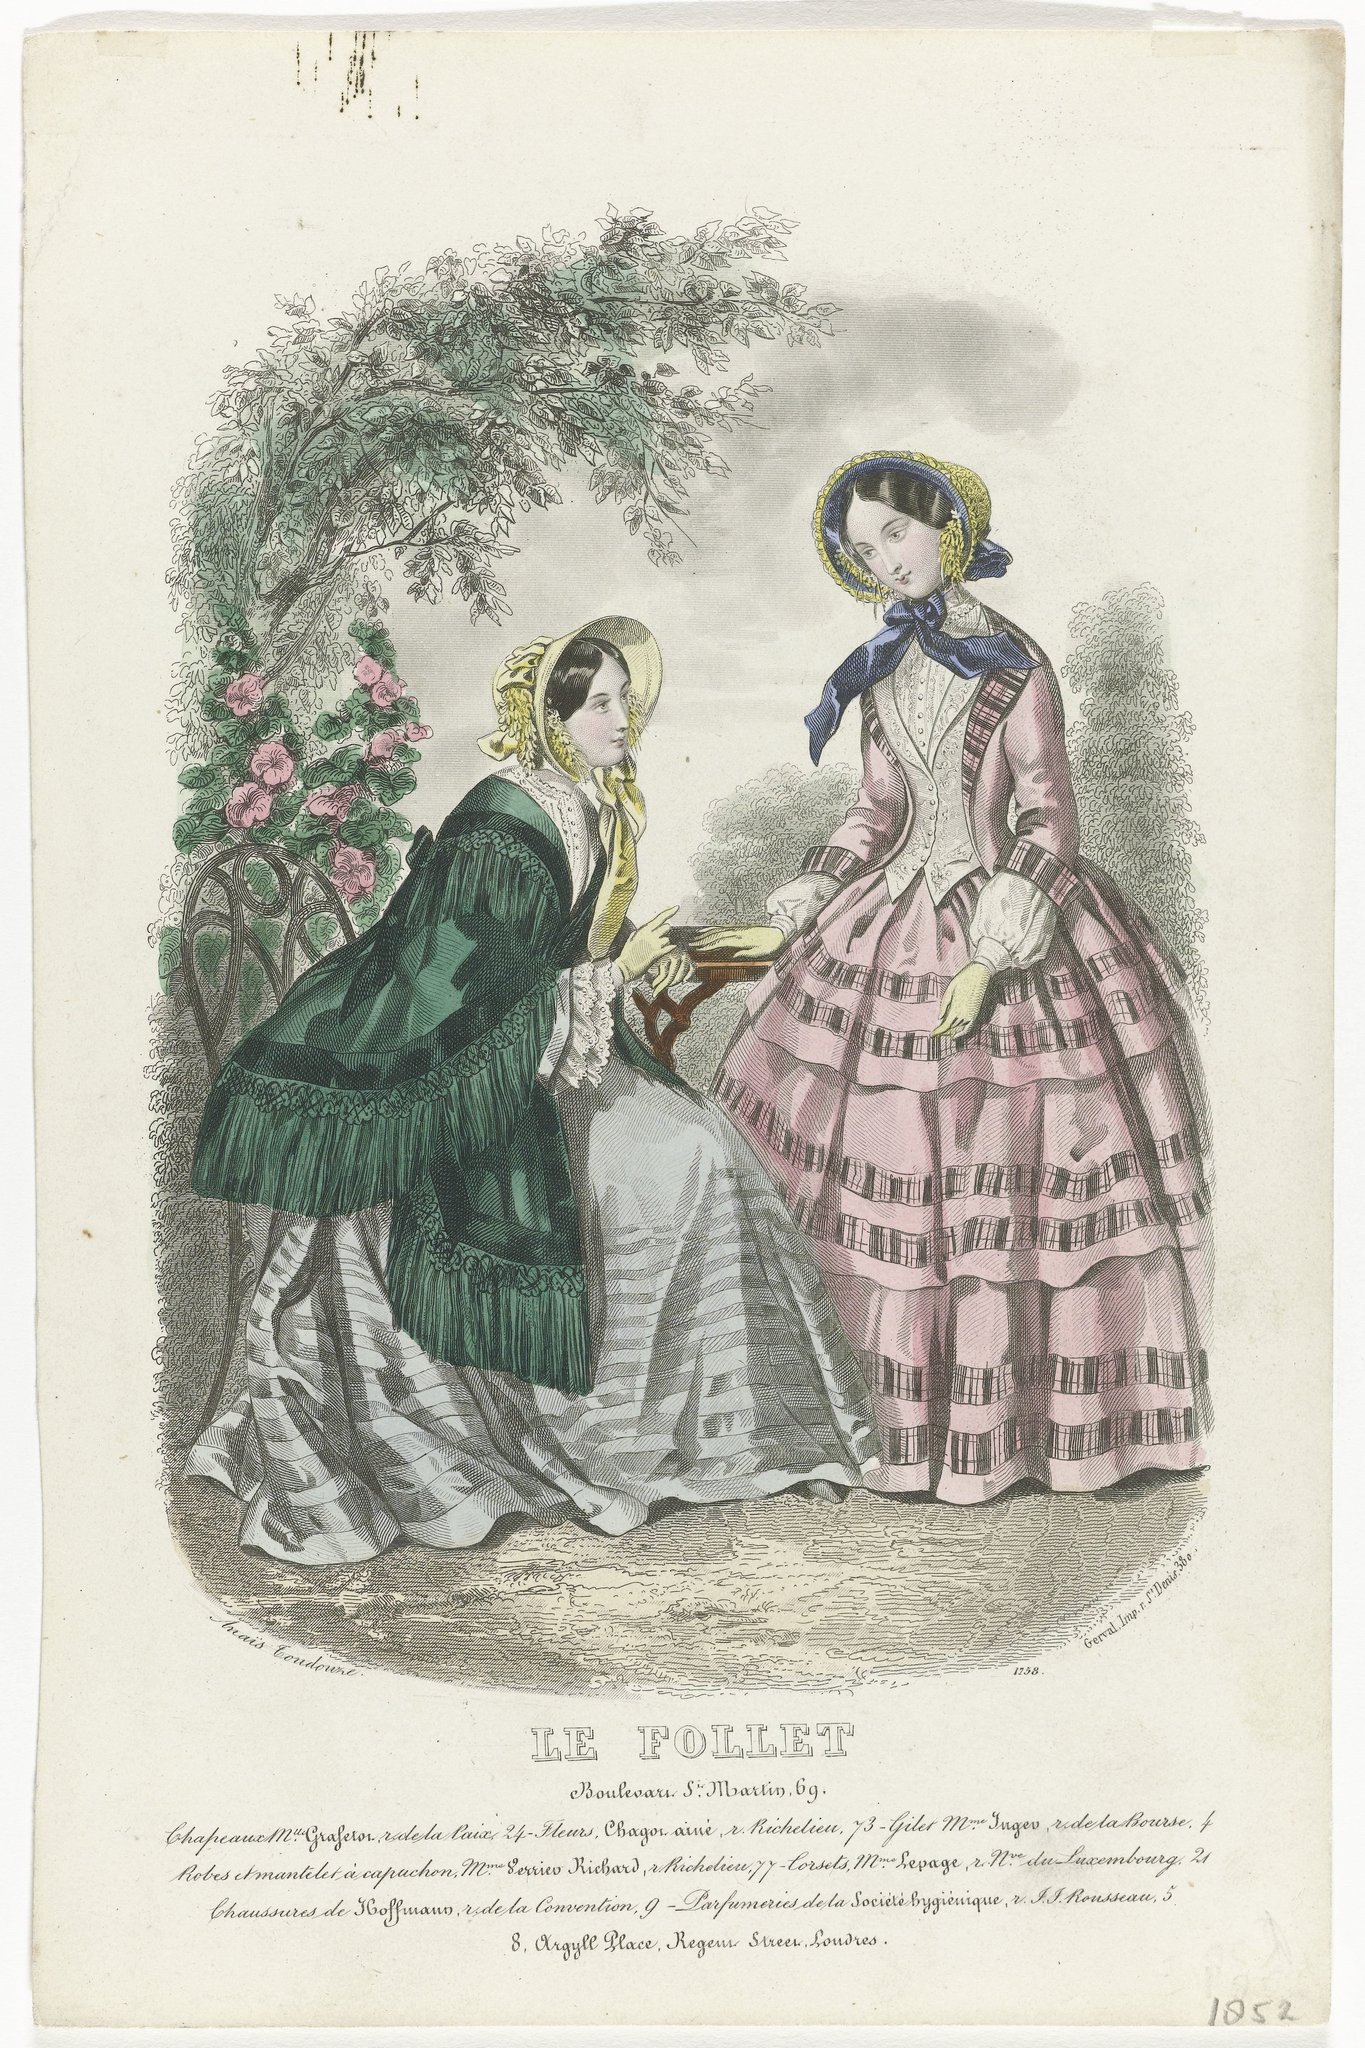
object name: fashion print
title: Le Follet, 1852, No. 1758 : Chapeaux M.lle Grafetor (...)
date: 1852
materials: paper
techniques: hand coloring, engraving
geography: paris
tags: clothing for the upper part of the body (vest) (+ women's clothes), head-gear: hood (+ women's clothes), clothing for the upper part of the body (mantelet) (+ women's clothes), fashion plates, head-gear: hat (+ women's clothes), skirt (+ women's clothes), gloves, mittens, etc. (+ women's clothes), mourning customs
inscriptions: address: ‘Boulevart S.t Martin, 69 / 8, Argyll Place, Regent Street, Londres.’, caption: ‘Chapeaux M.lle Grafetor, r. de la Paix, 24- Fleurs, Chagot ainé, r. Richlieu, 73-Gilet M.me Inger, r. de la Bourse, 4 Robes et mantelet à capuchon, M.me Verrier Richard, r. Richelieu, 77- Corsets, M.me Lepage, r. N.ve du Luxembourg, 21 Chaussures de Hoffmann, r. de la Convention, 9 - Parfumeries de la Société Hygiénique, r. J.J. Rousseau, 5.’, title: ‘Le Follet’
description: Twee vrouwen in een tuin. Volgens het onderschrift: hoeden van Grafetor. Vest van Inger. Japonnen en mantelet met capuchon van Verrier Richard. Hieronder enkele regels reclametekst voor verschillende producten. Prent uit het modetijdschrift Le Follet Courrier des Salons (novembre 1829-octobre 1882).